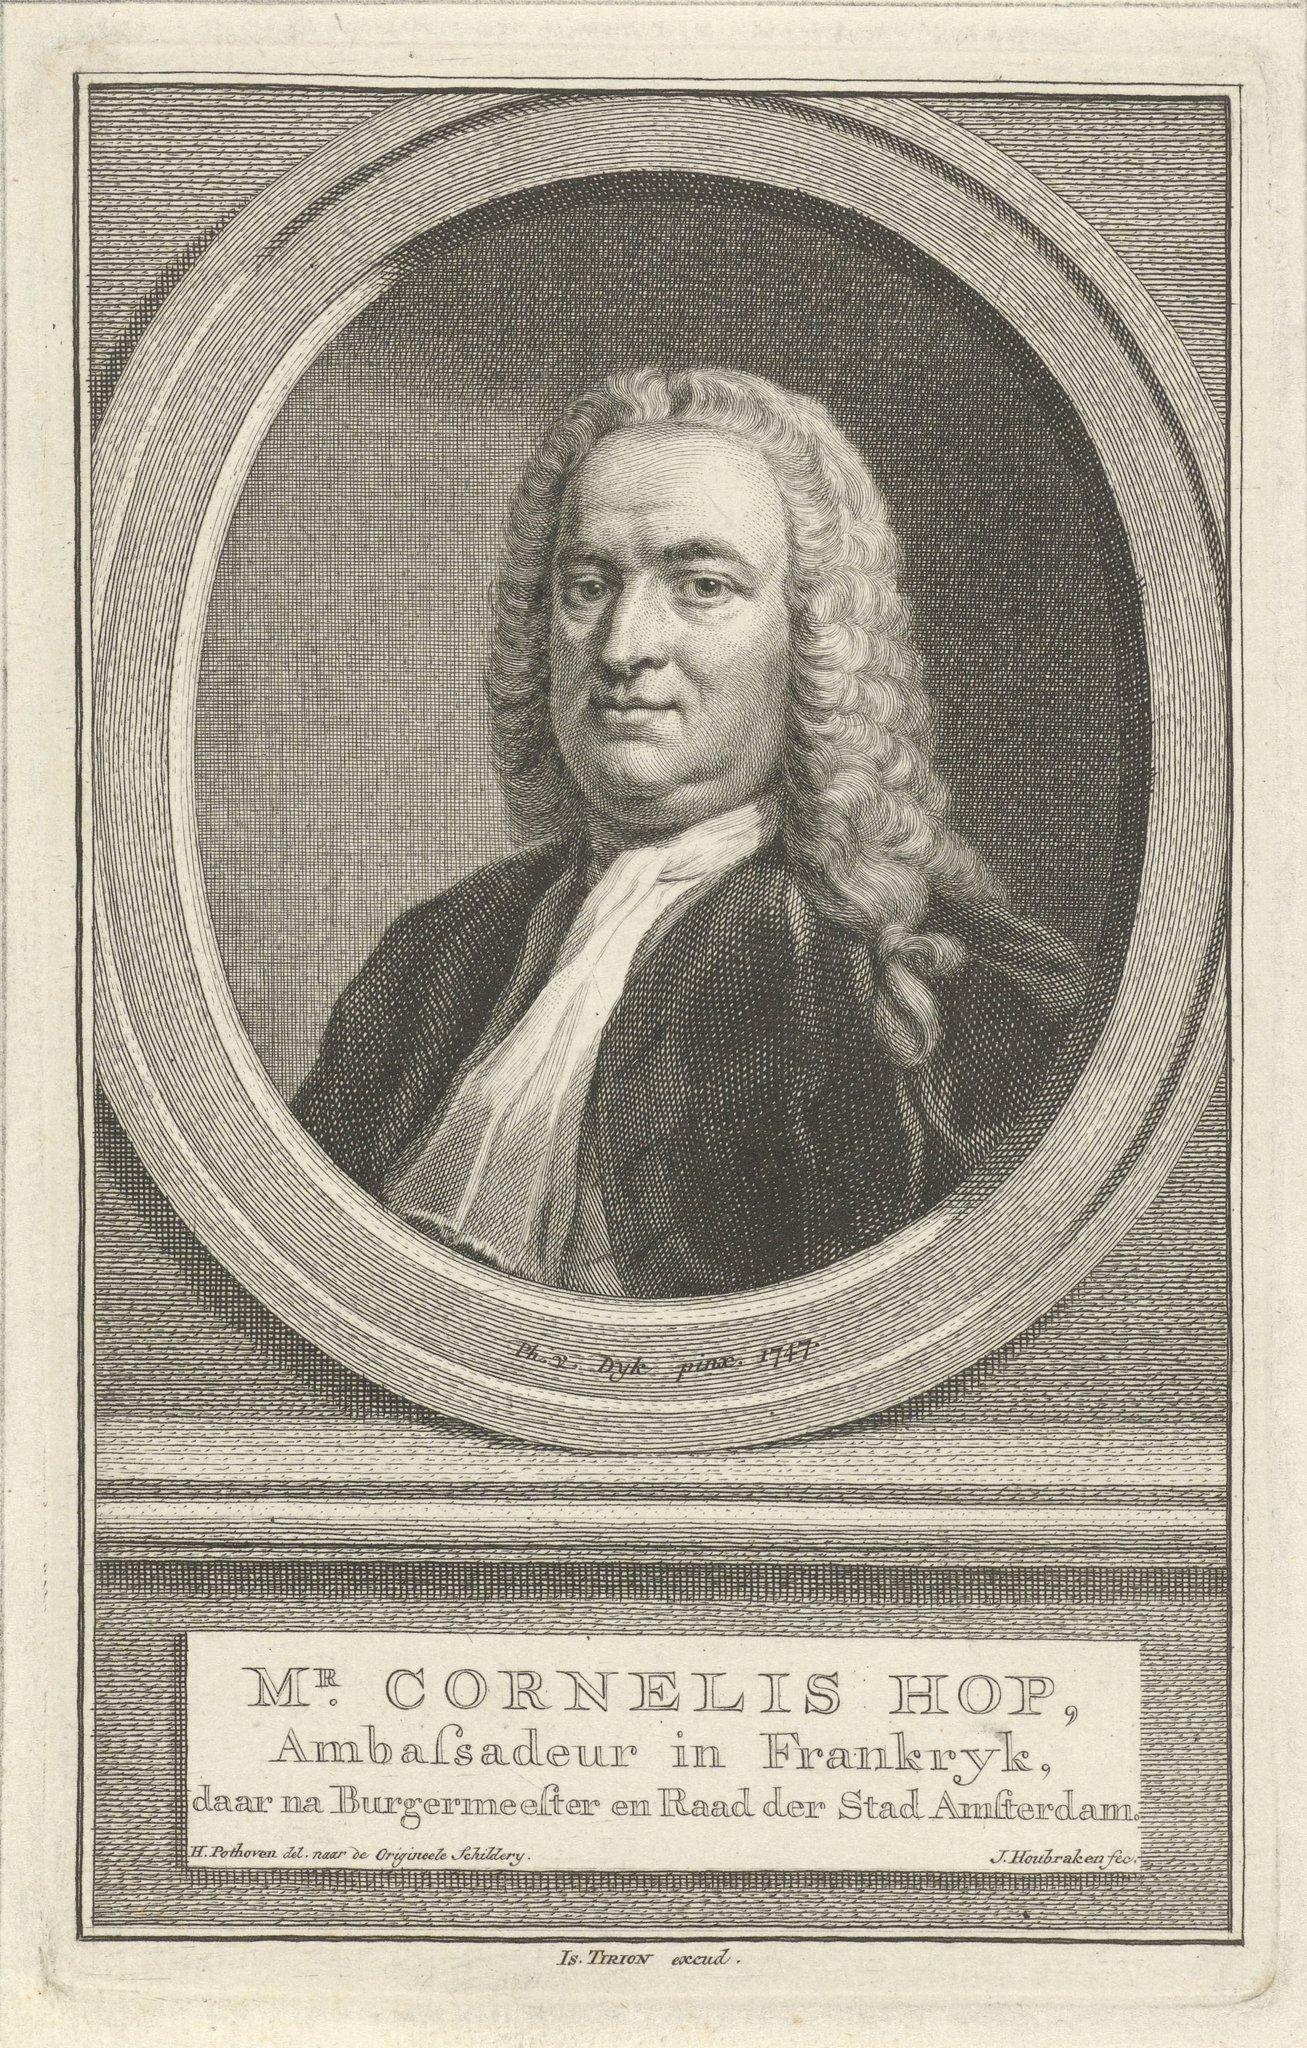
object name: print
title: Portret van Cornelis Hop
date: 1749-1759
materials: paper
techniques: engraving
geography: amsterdam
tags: cornelis hop (ii)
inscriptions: collector's mark: Lugt 2228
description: Prent ook gebruikt in: Jan Wagenaar, Vaderlandsche historie, vervattende de geschiedenissen der nu Vereenigde Nederlanden, inzonderheid die van Holland (...), 21 delen. Amsterdam, Isaak Tirion, 1749-59.